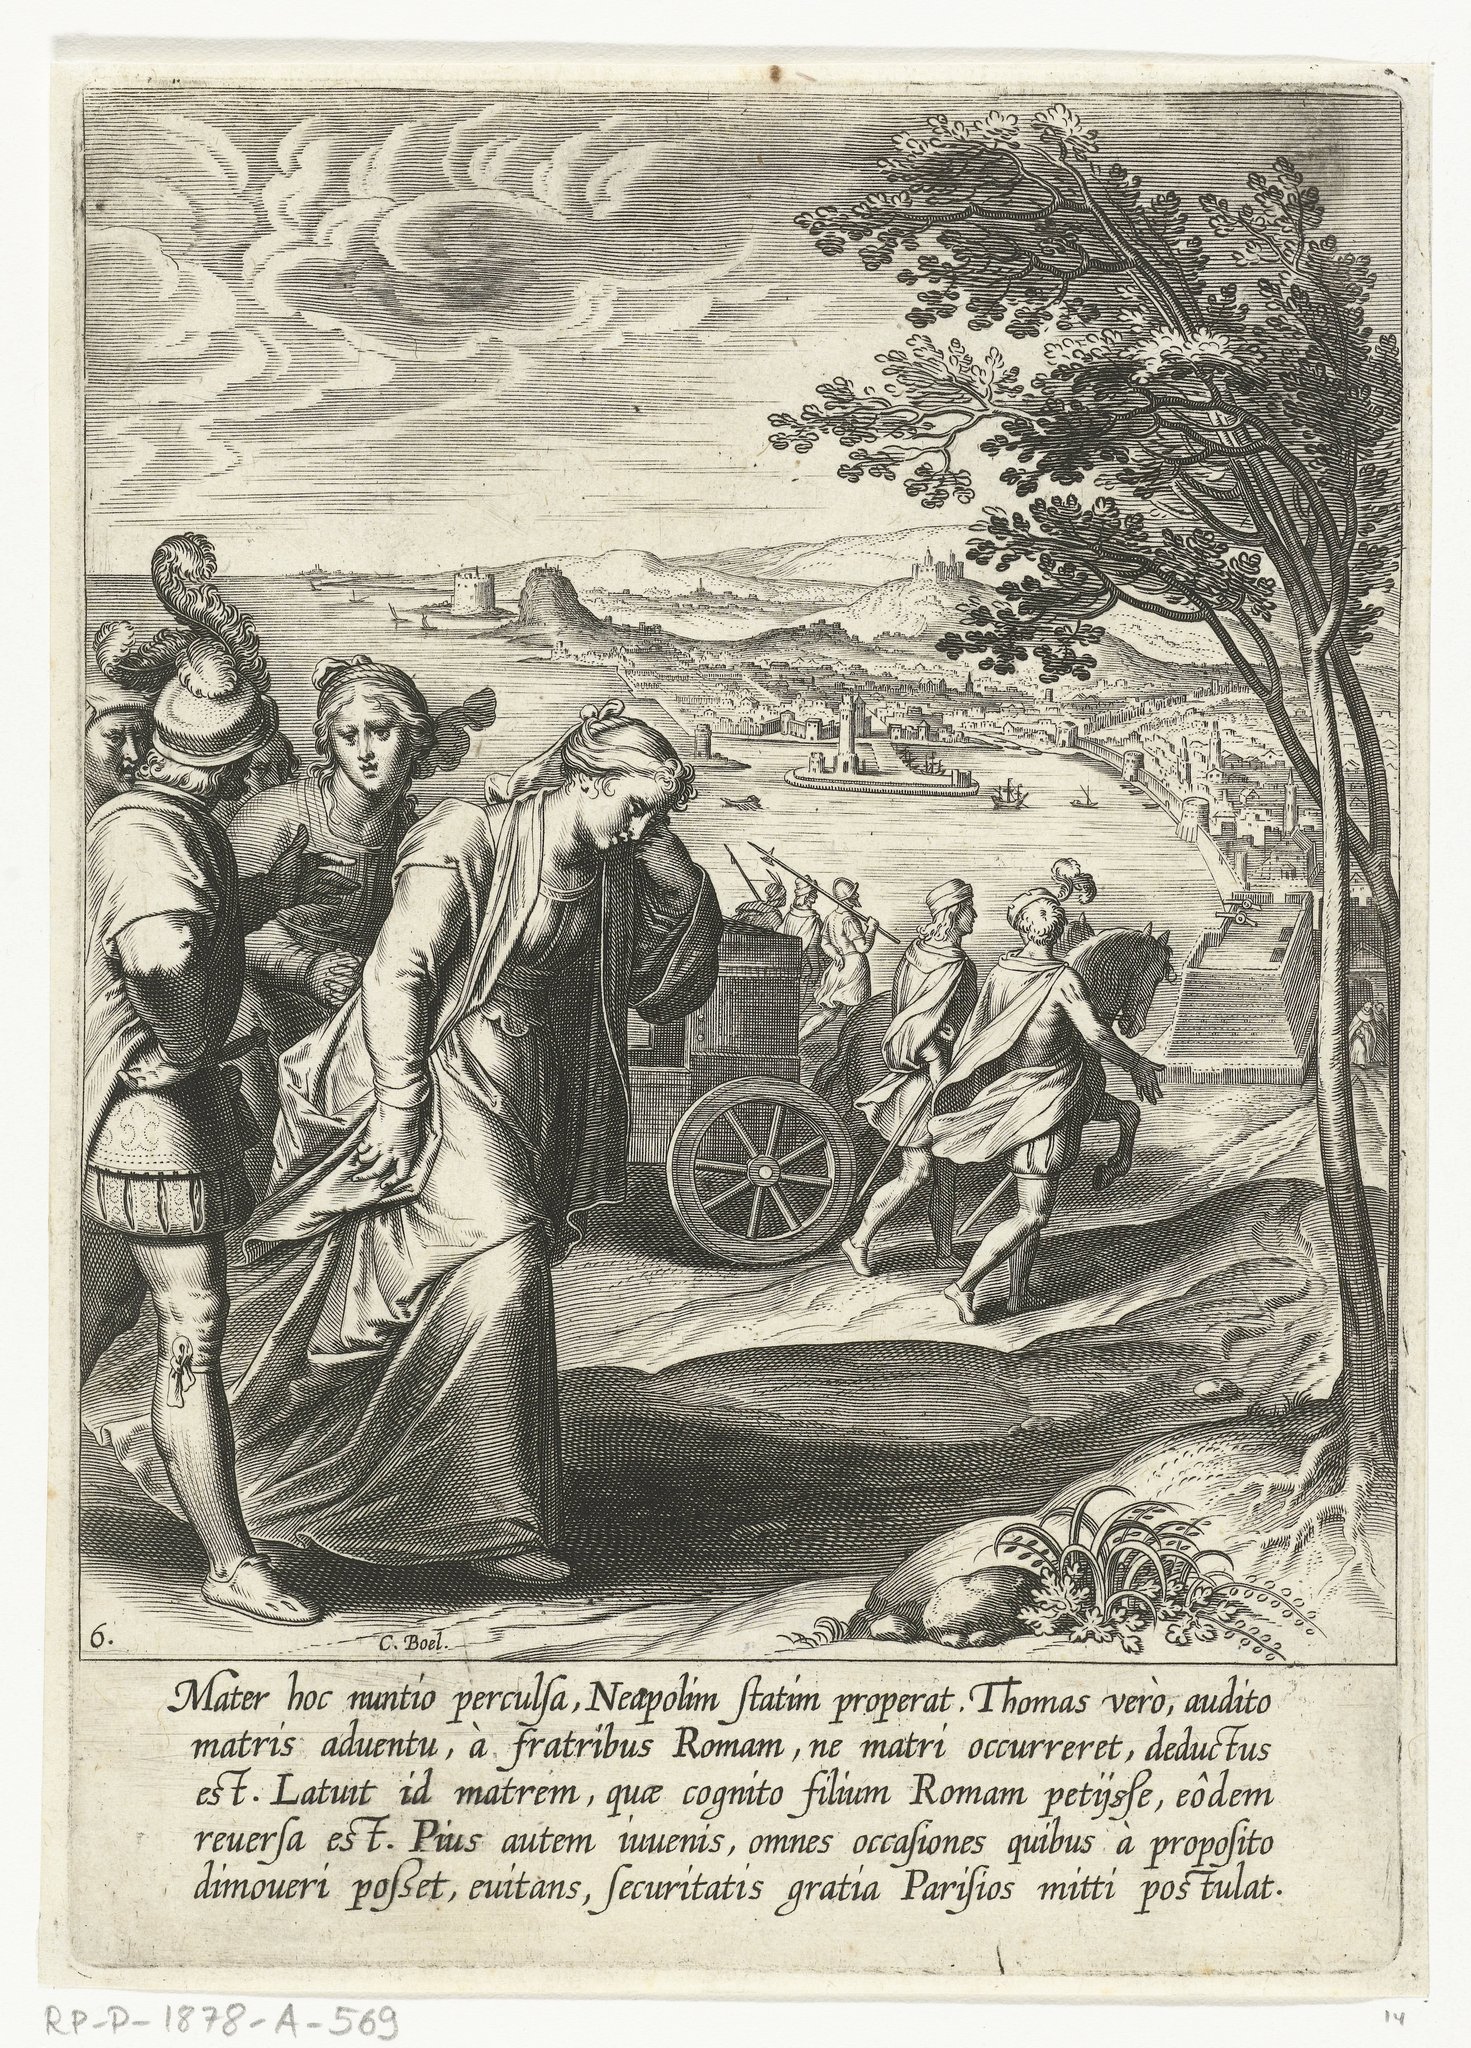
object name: print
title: Thomas moeder op zoek naar hem in Napels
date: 1610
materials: paper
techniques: engraving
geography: southern netherlands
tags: thomas van aquino, the dominican theologian, 'angelic doctor' thomas of aquino; possible attributes: book, (chain with) sun, dove, girdle of chastity, lily, model of church, monstrance (or chalice), mitre (under feet), star (on breast)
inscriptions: collector's mark: Lugt 2228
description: De moeder van de heilige Thomas van Aquino is op zoek naar haar zoon in de stad Napels. Hij is echter al doorgereisd naar Rome. Prent uit een serie van 30 prenten die het levensverhaal van Thomas van Aquino verbeelden. De prenten, naar ontwerp van en uitgegeven door Otto van Veen, zijn door C. Boel, E. van Paenderen, C. Galle en G. Swanenburgh vervaardigd.